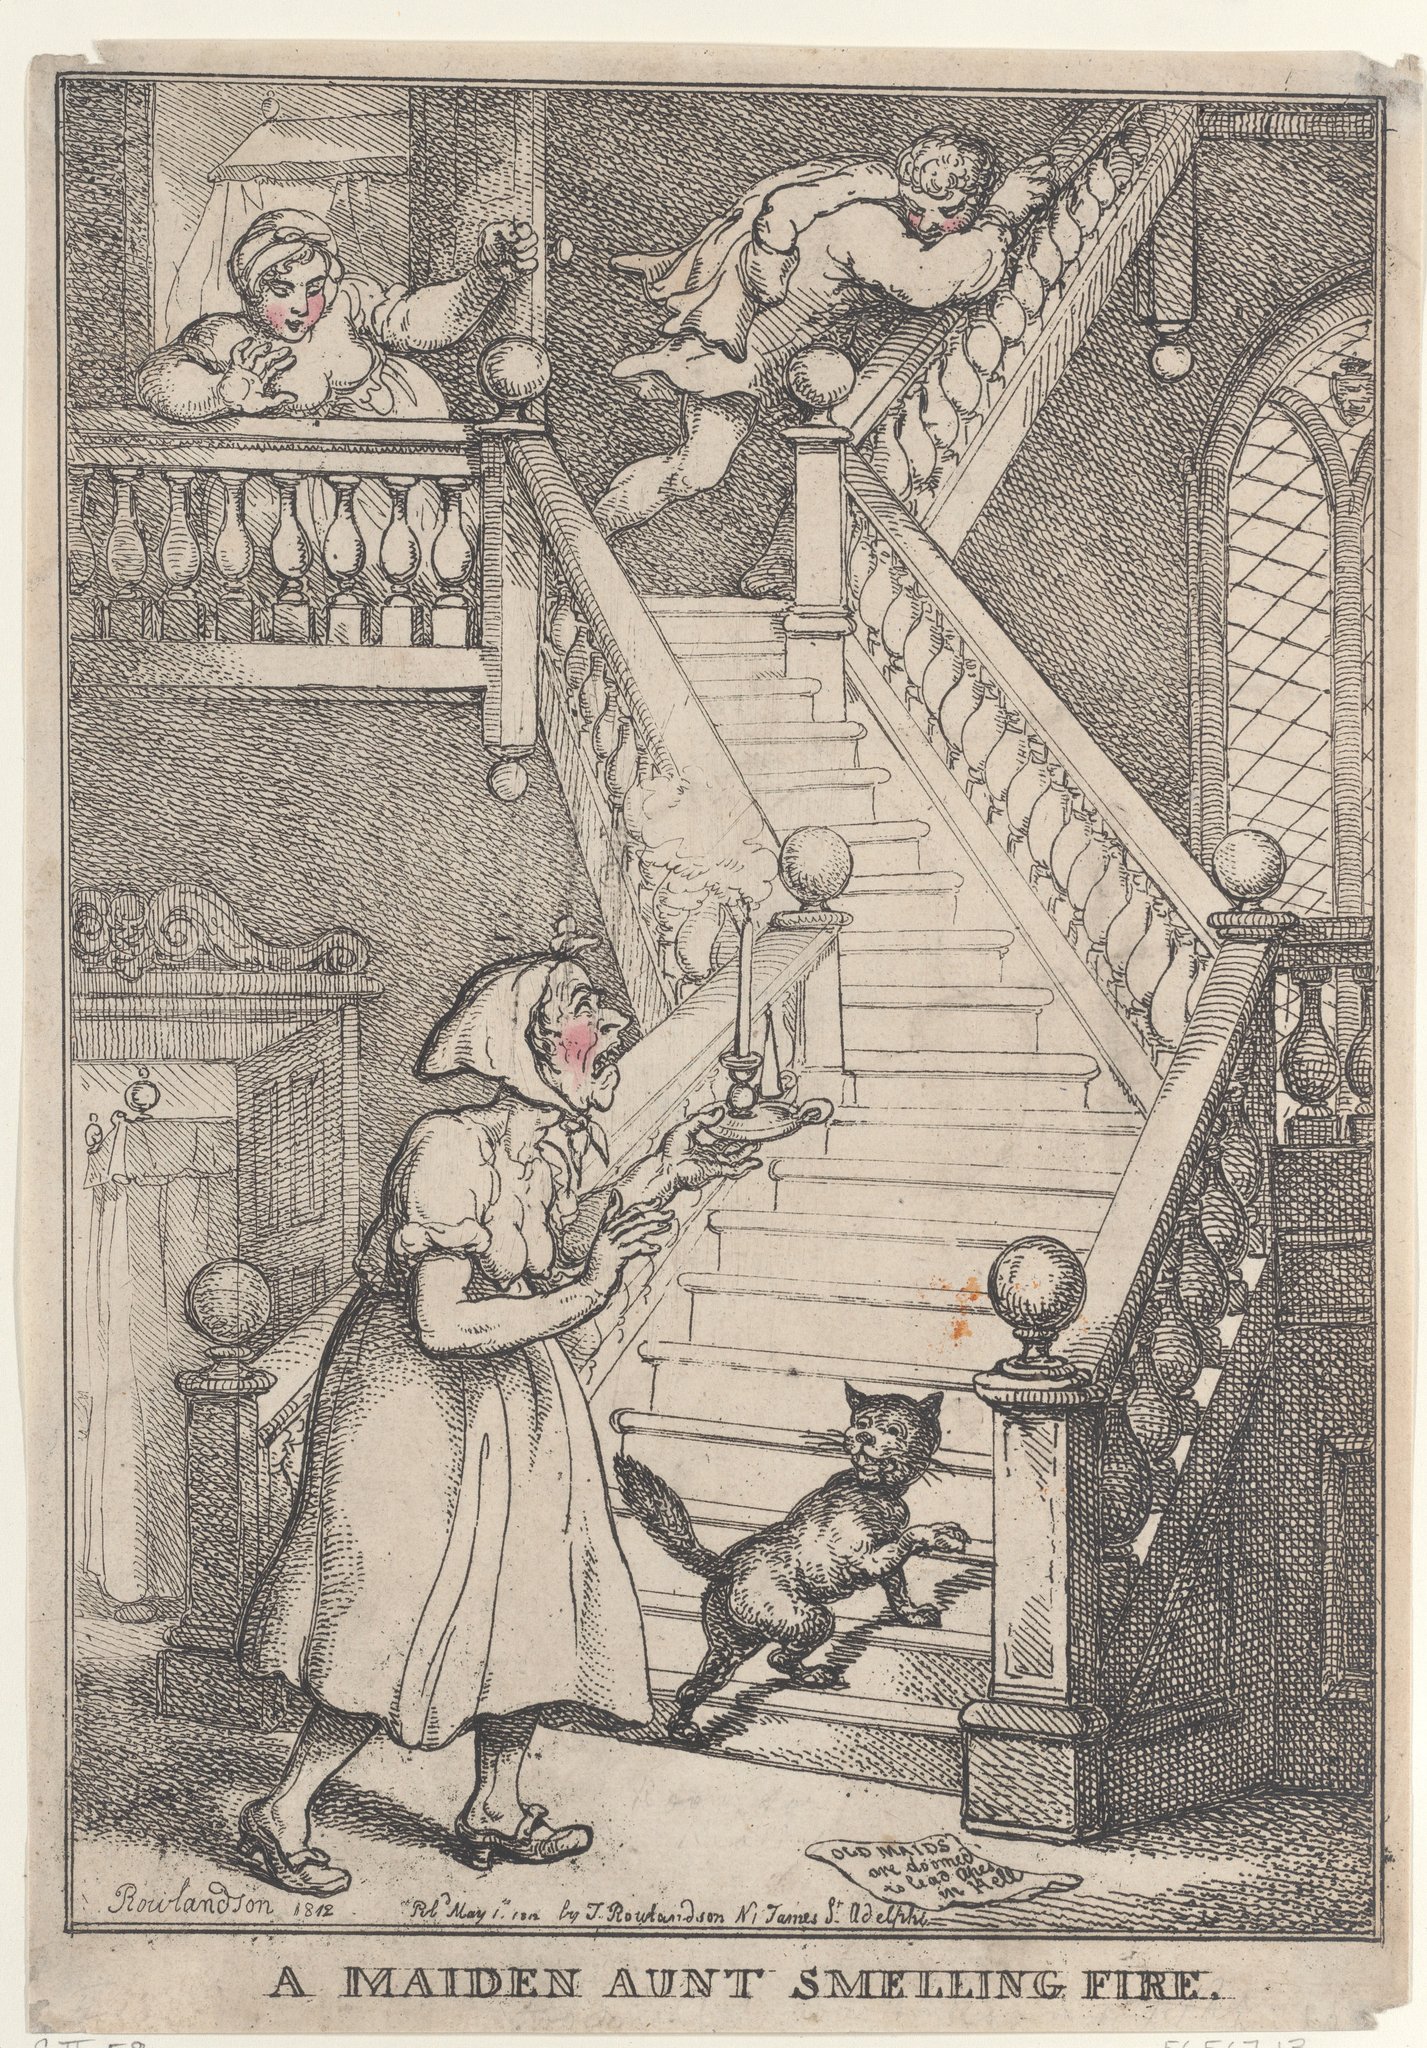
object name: print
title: A Maiden Aunt Smelling Fire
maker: thomas rowlandson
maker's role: artist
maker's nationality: british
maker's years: 1757-1827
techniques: etching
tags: stairs,men,women,cats